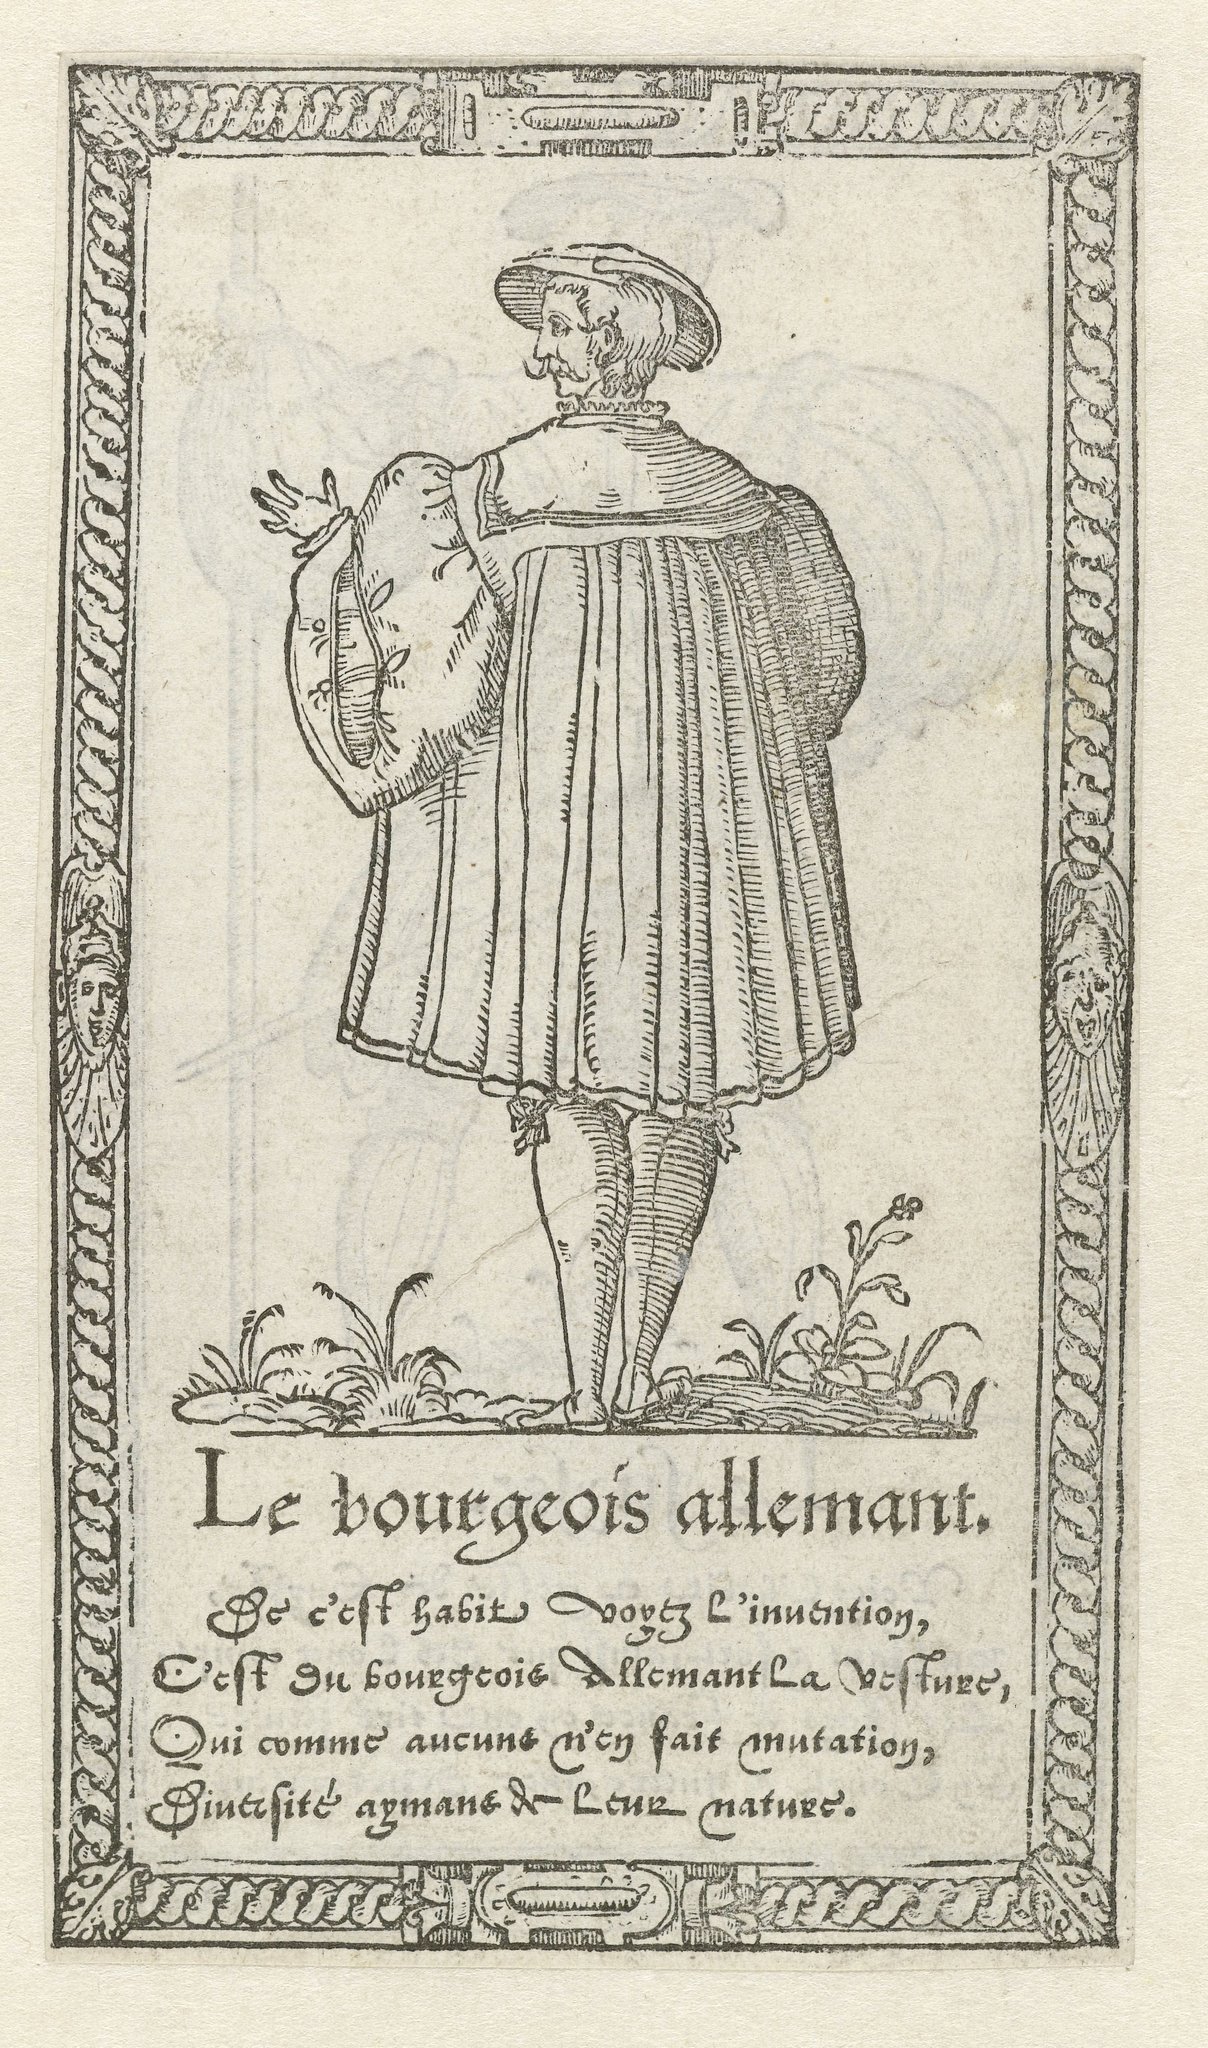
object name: print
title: Recueil de la diversité des habits (A Collection of the Various Styles of Clothing)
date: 1562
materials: paper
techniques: woodcut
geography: paris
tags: coat (+ men's clothes), fashion plates, europeans: germans (+ costume), bourgeoisie, middle class, citizens, burghers, folk costume, regional costume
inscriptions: collector's mark: Lugt 2228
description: This is the very first costume book, with more than a hundred images of clothing from around the world. Below each figure are four lines of verse describing the country’s outfits or related customs. This was an age of unprecedented overseas exploration. Europeans were especially fascinated to see and read about inhabitants of the so-called New World, such as the Brazilian woman with her child 1.